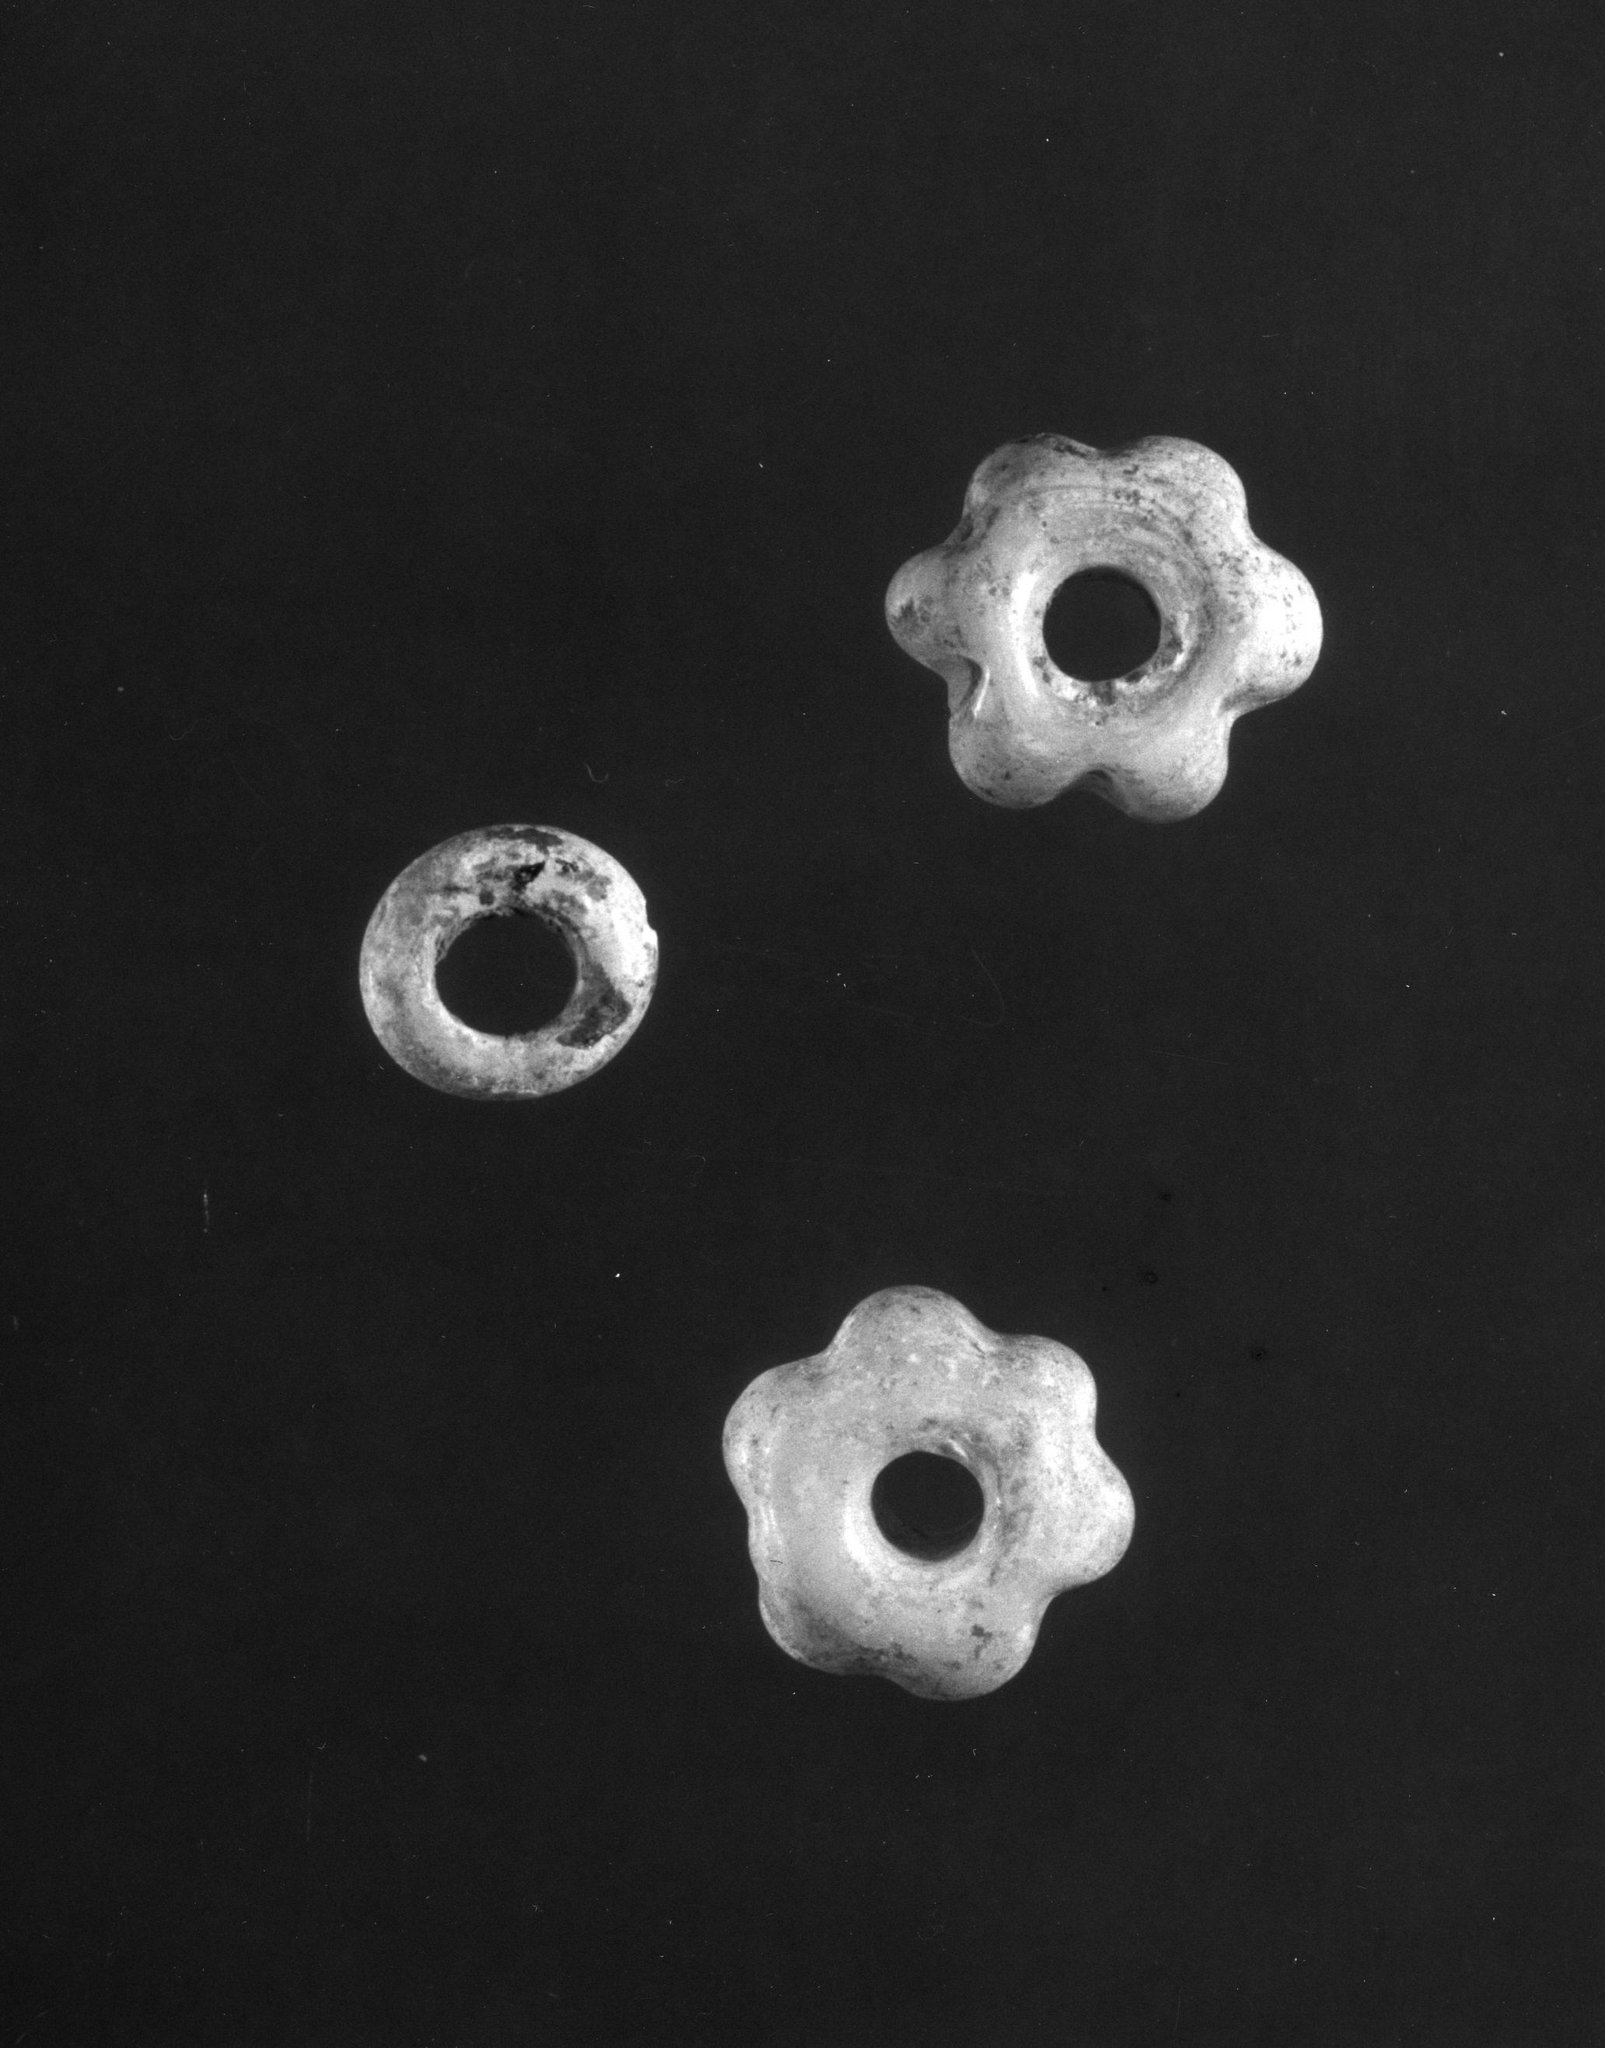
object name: bead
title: Three Small Beads, Cog-Wheel-Shaped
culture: chinese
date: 471-231 BCE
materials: glass